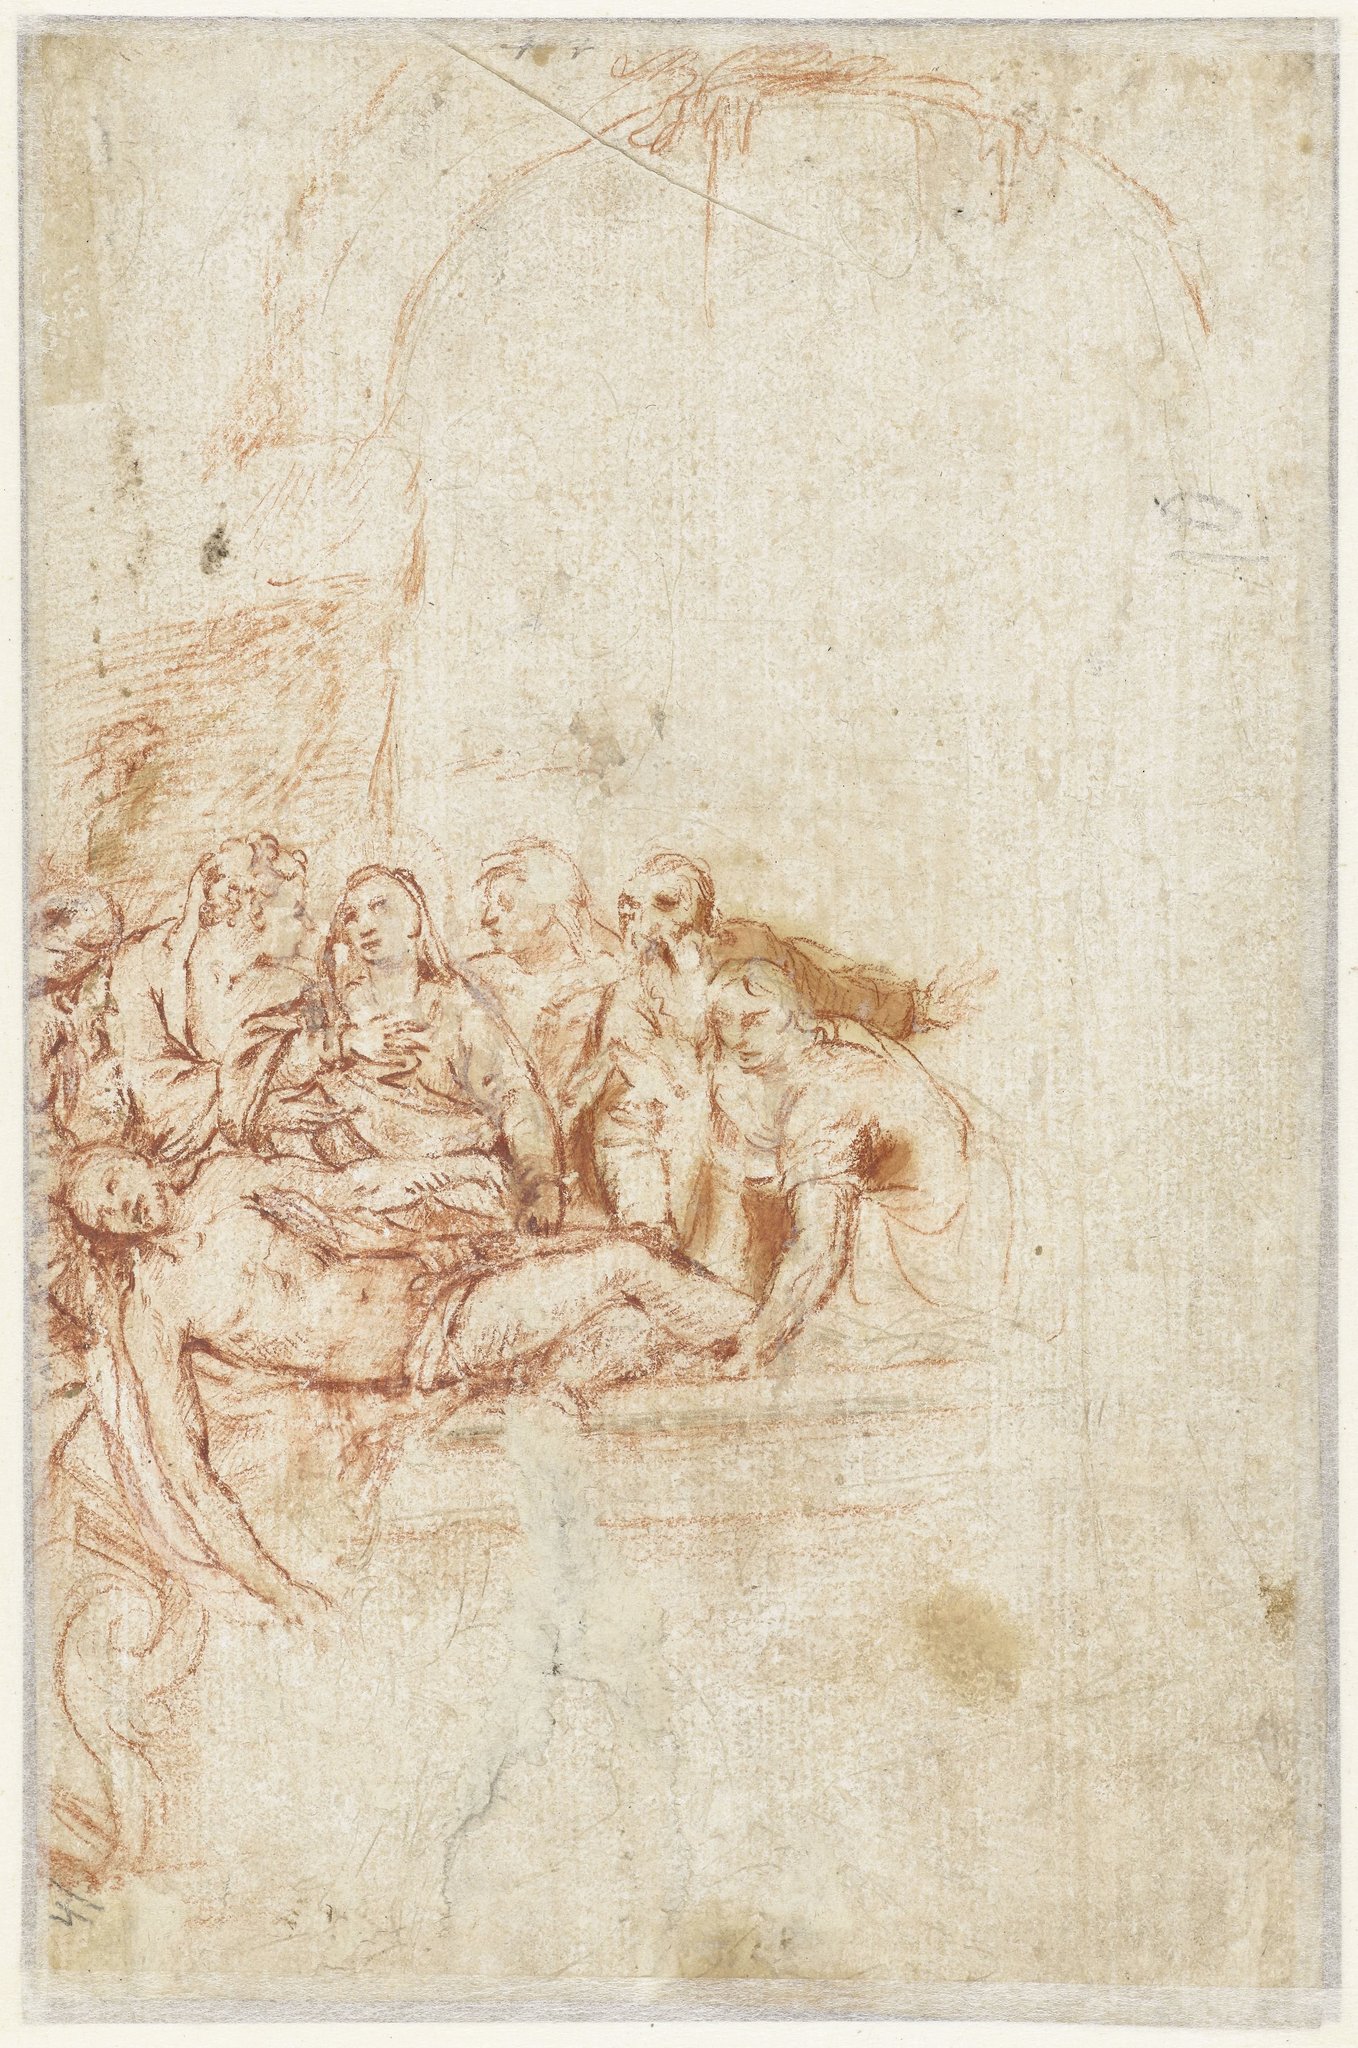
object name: drawing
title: Graflegging van Christus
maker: christoph schwarz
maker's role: draughtsman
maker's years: 1545-1592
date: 1555-1592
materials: chalk, paper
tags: christ's entombment (possibly by angels)